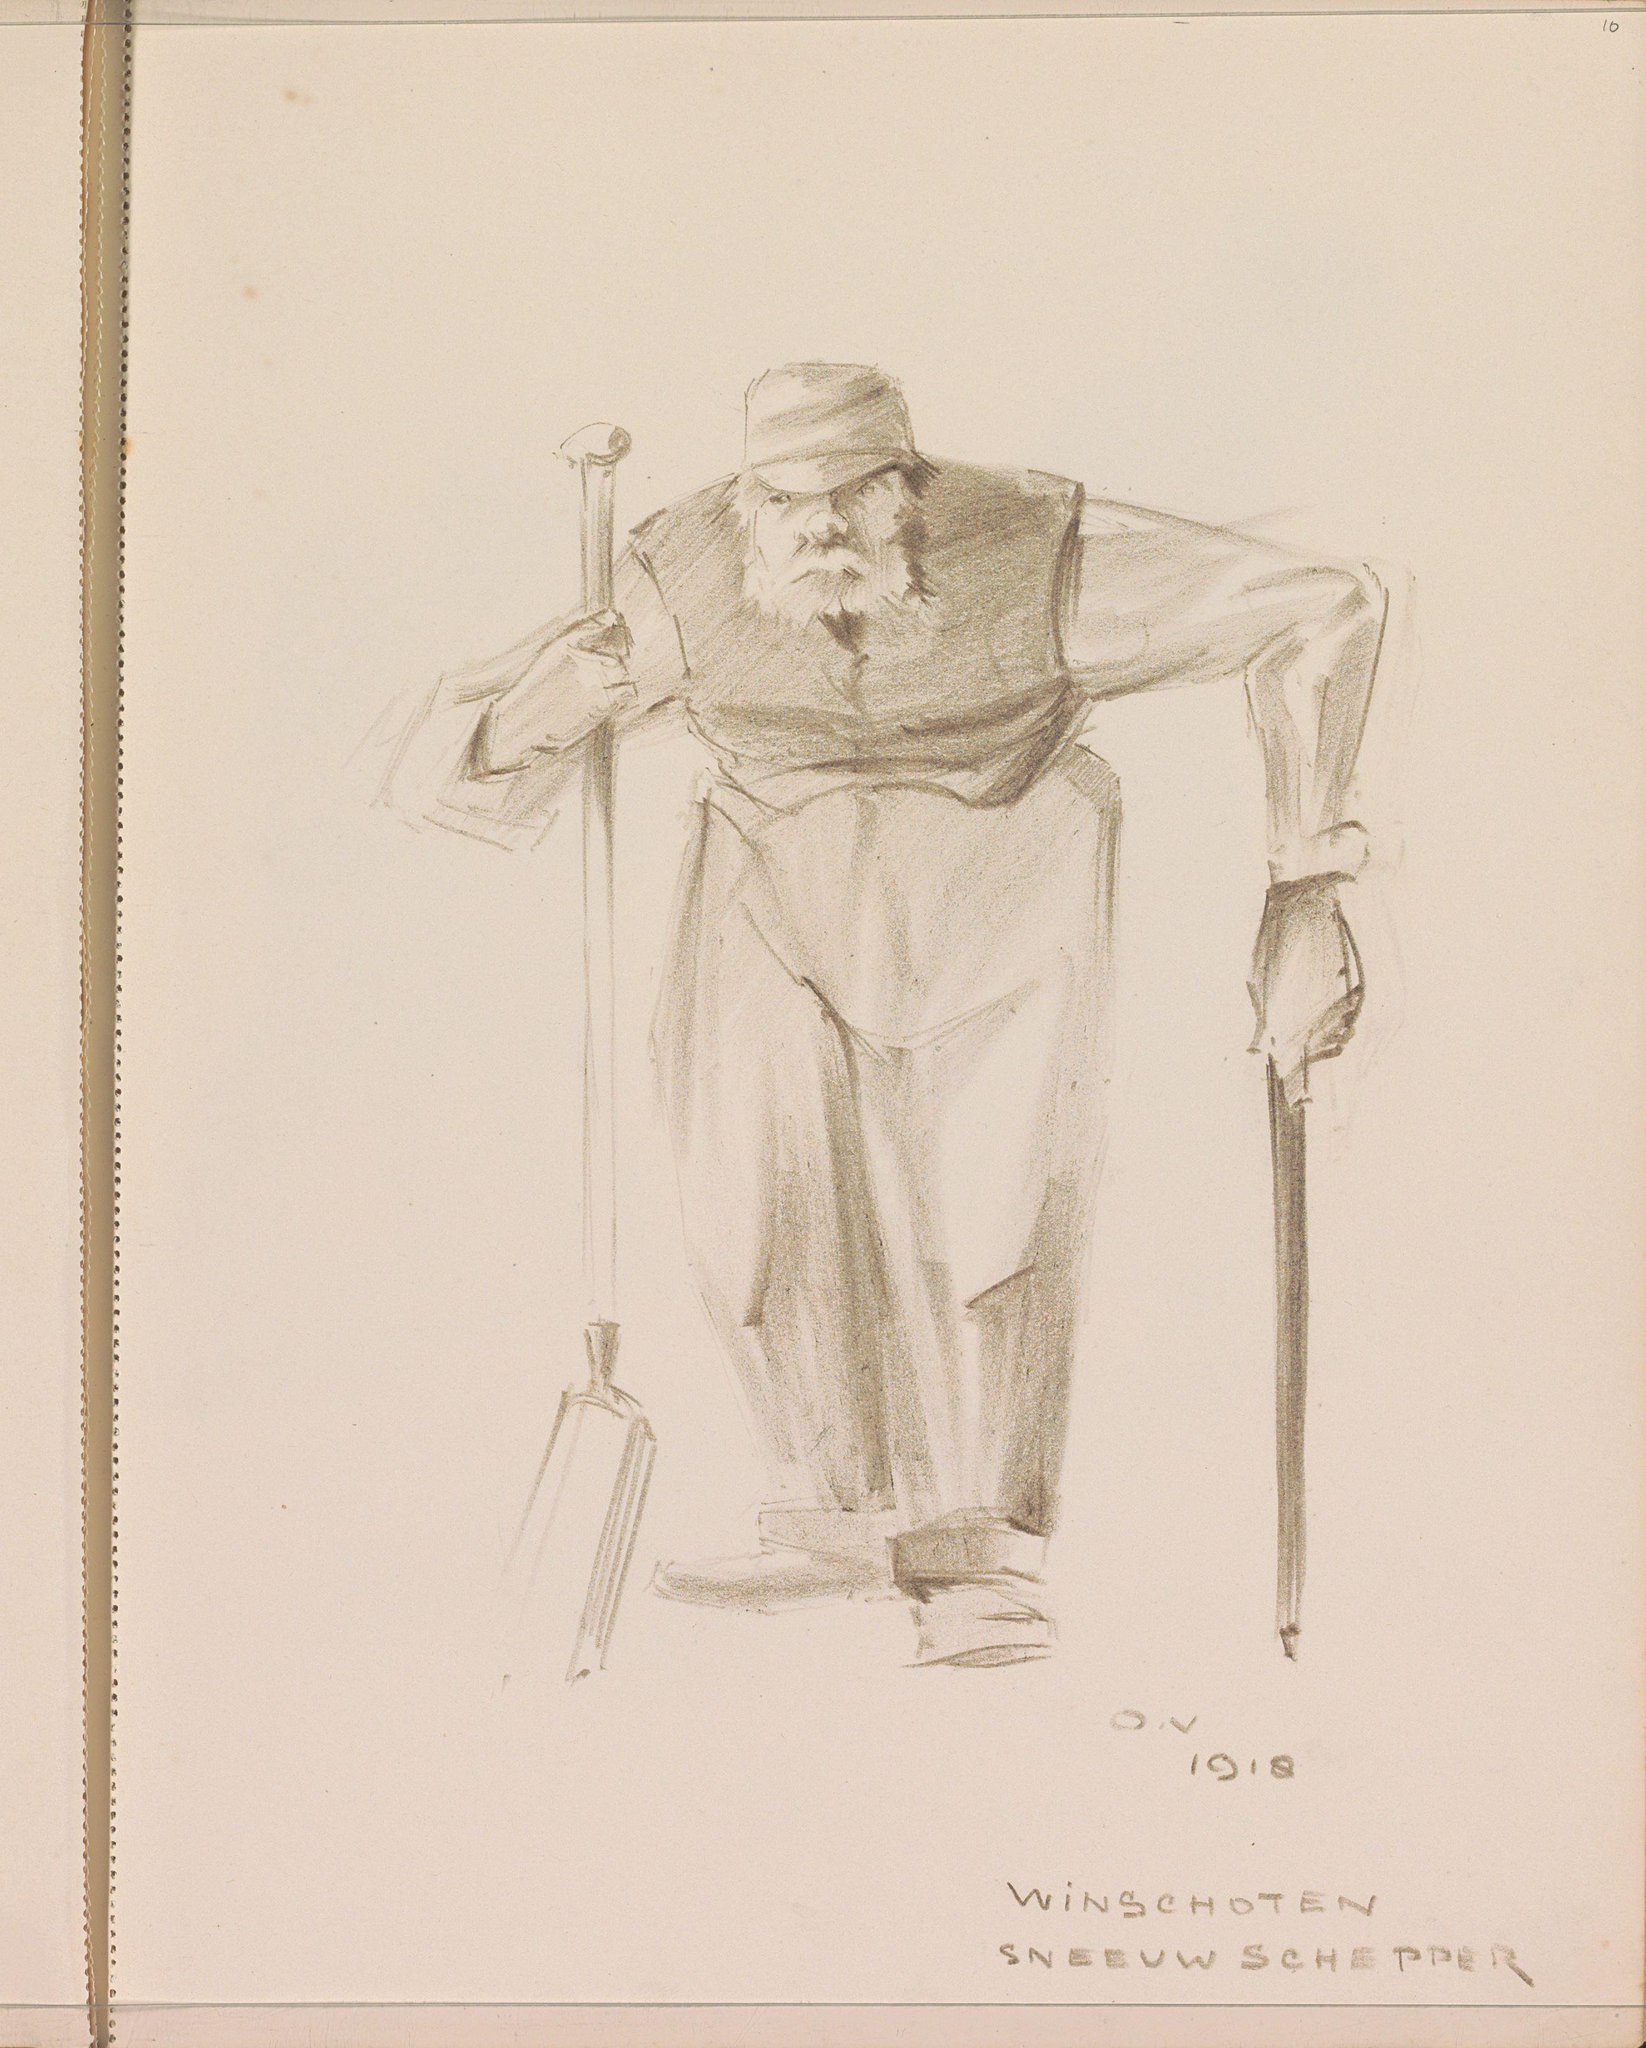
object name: sketchbook leaf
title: Winschoter sneeuwschepper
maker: otto verhagen (i)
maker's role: draughtsman, print maker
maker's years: 1885-1951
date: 1918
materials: chalk, paper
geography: winschoten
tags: bending figure, agricultural implements: spade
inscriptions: date and inscription: ‘o.v./ 1918/ WINSCHOTEN/ SNEEUWSCHEPPER’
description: Pagina 10 uit een schetsboek met 28 bladen.